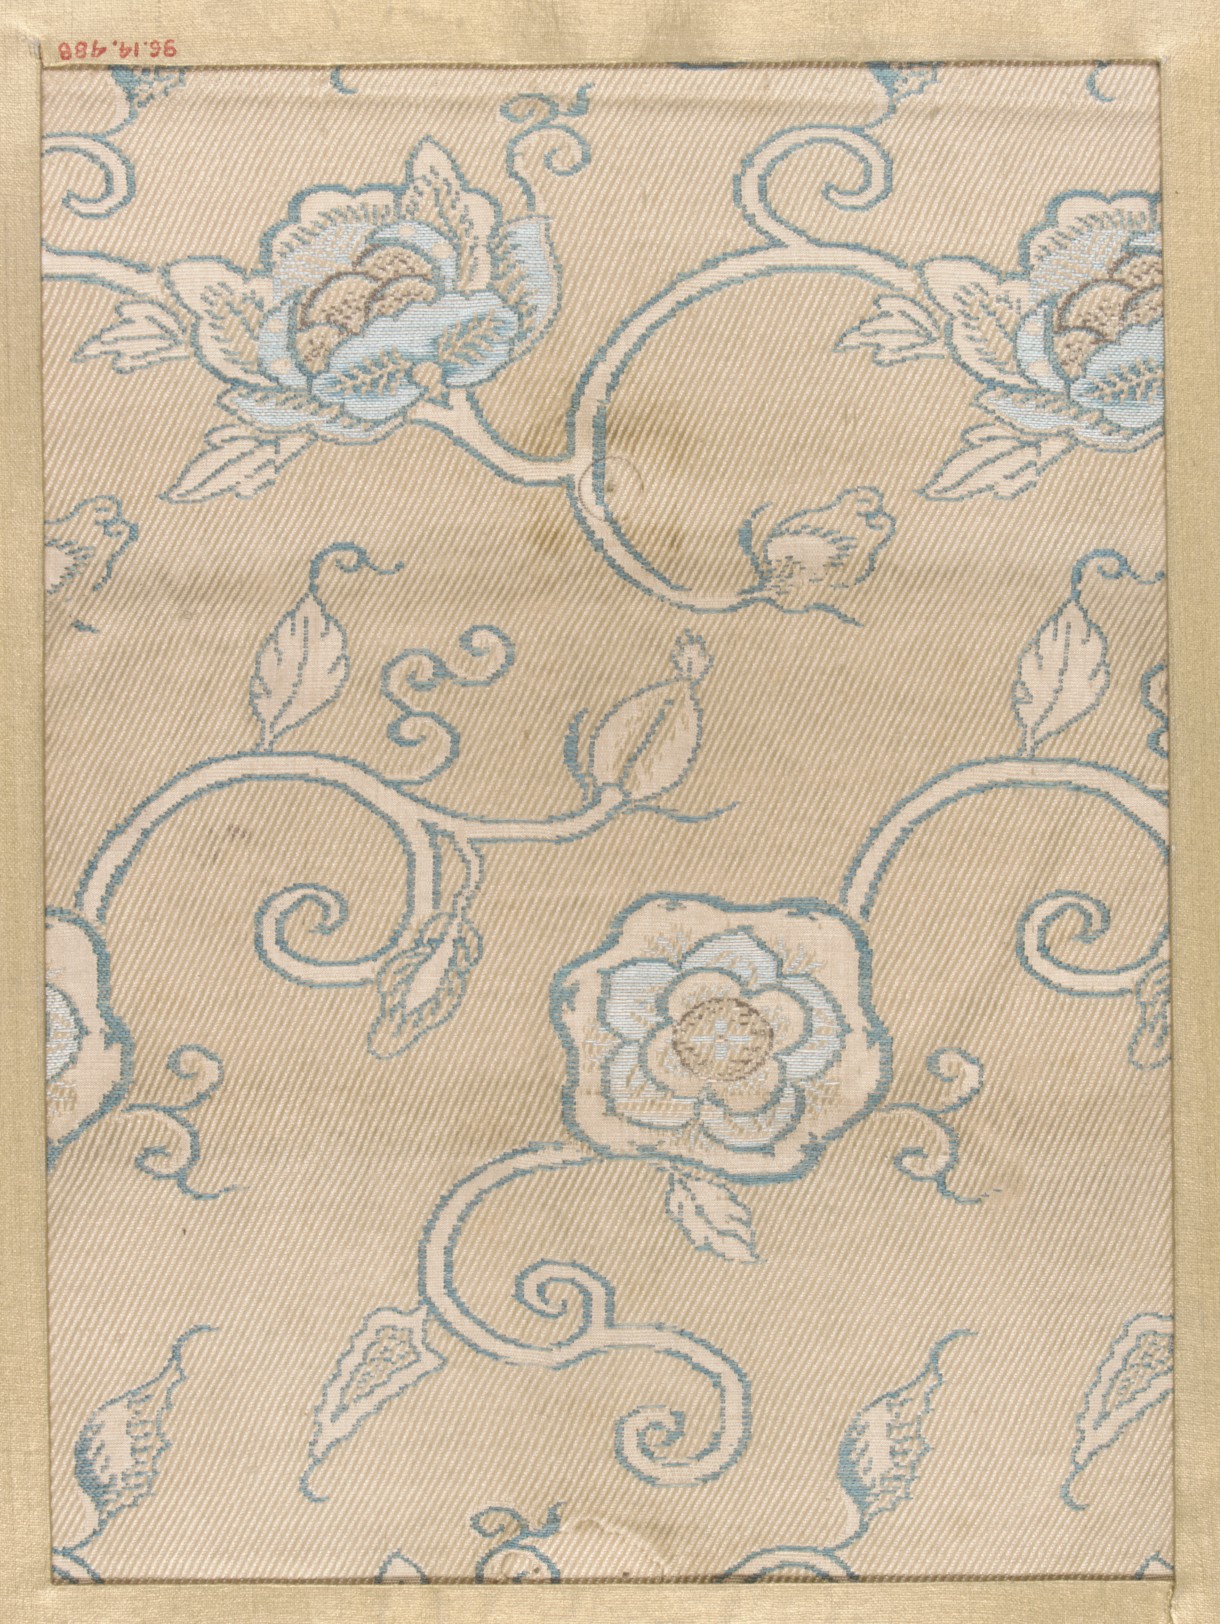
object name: piece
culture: japanese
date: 1701-1900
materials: silk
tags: leaves